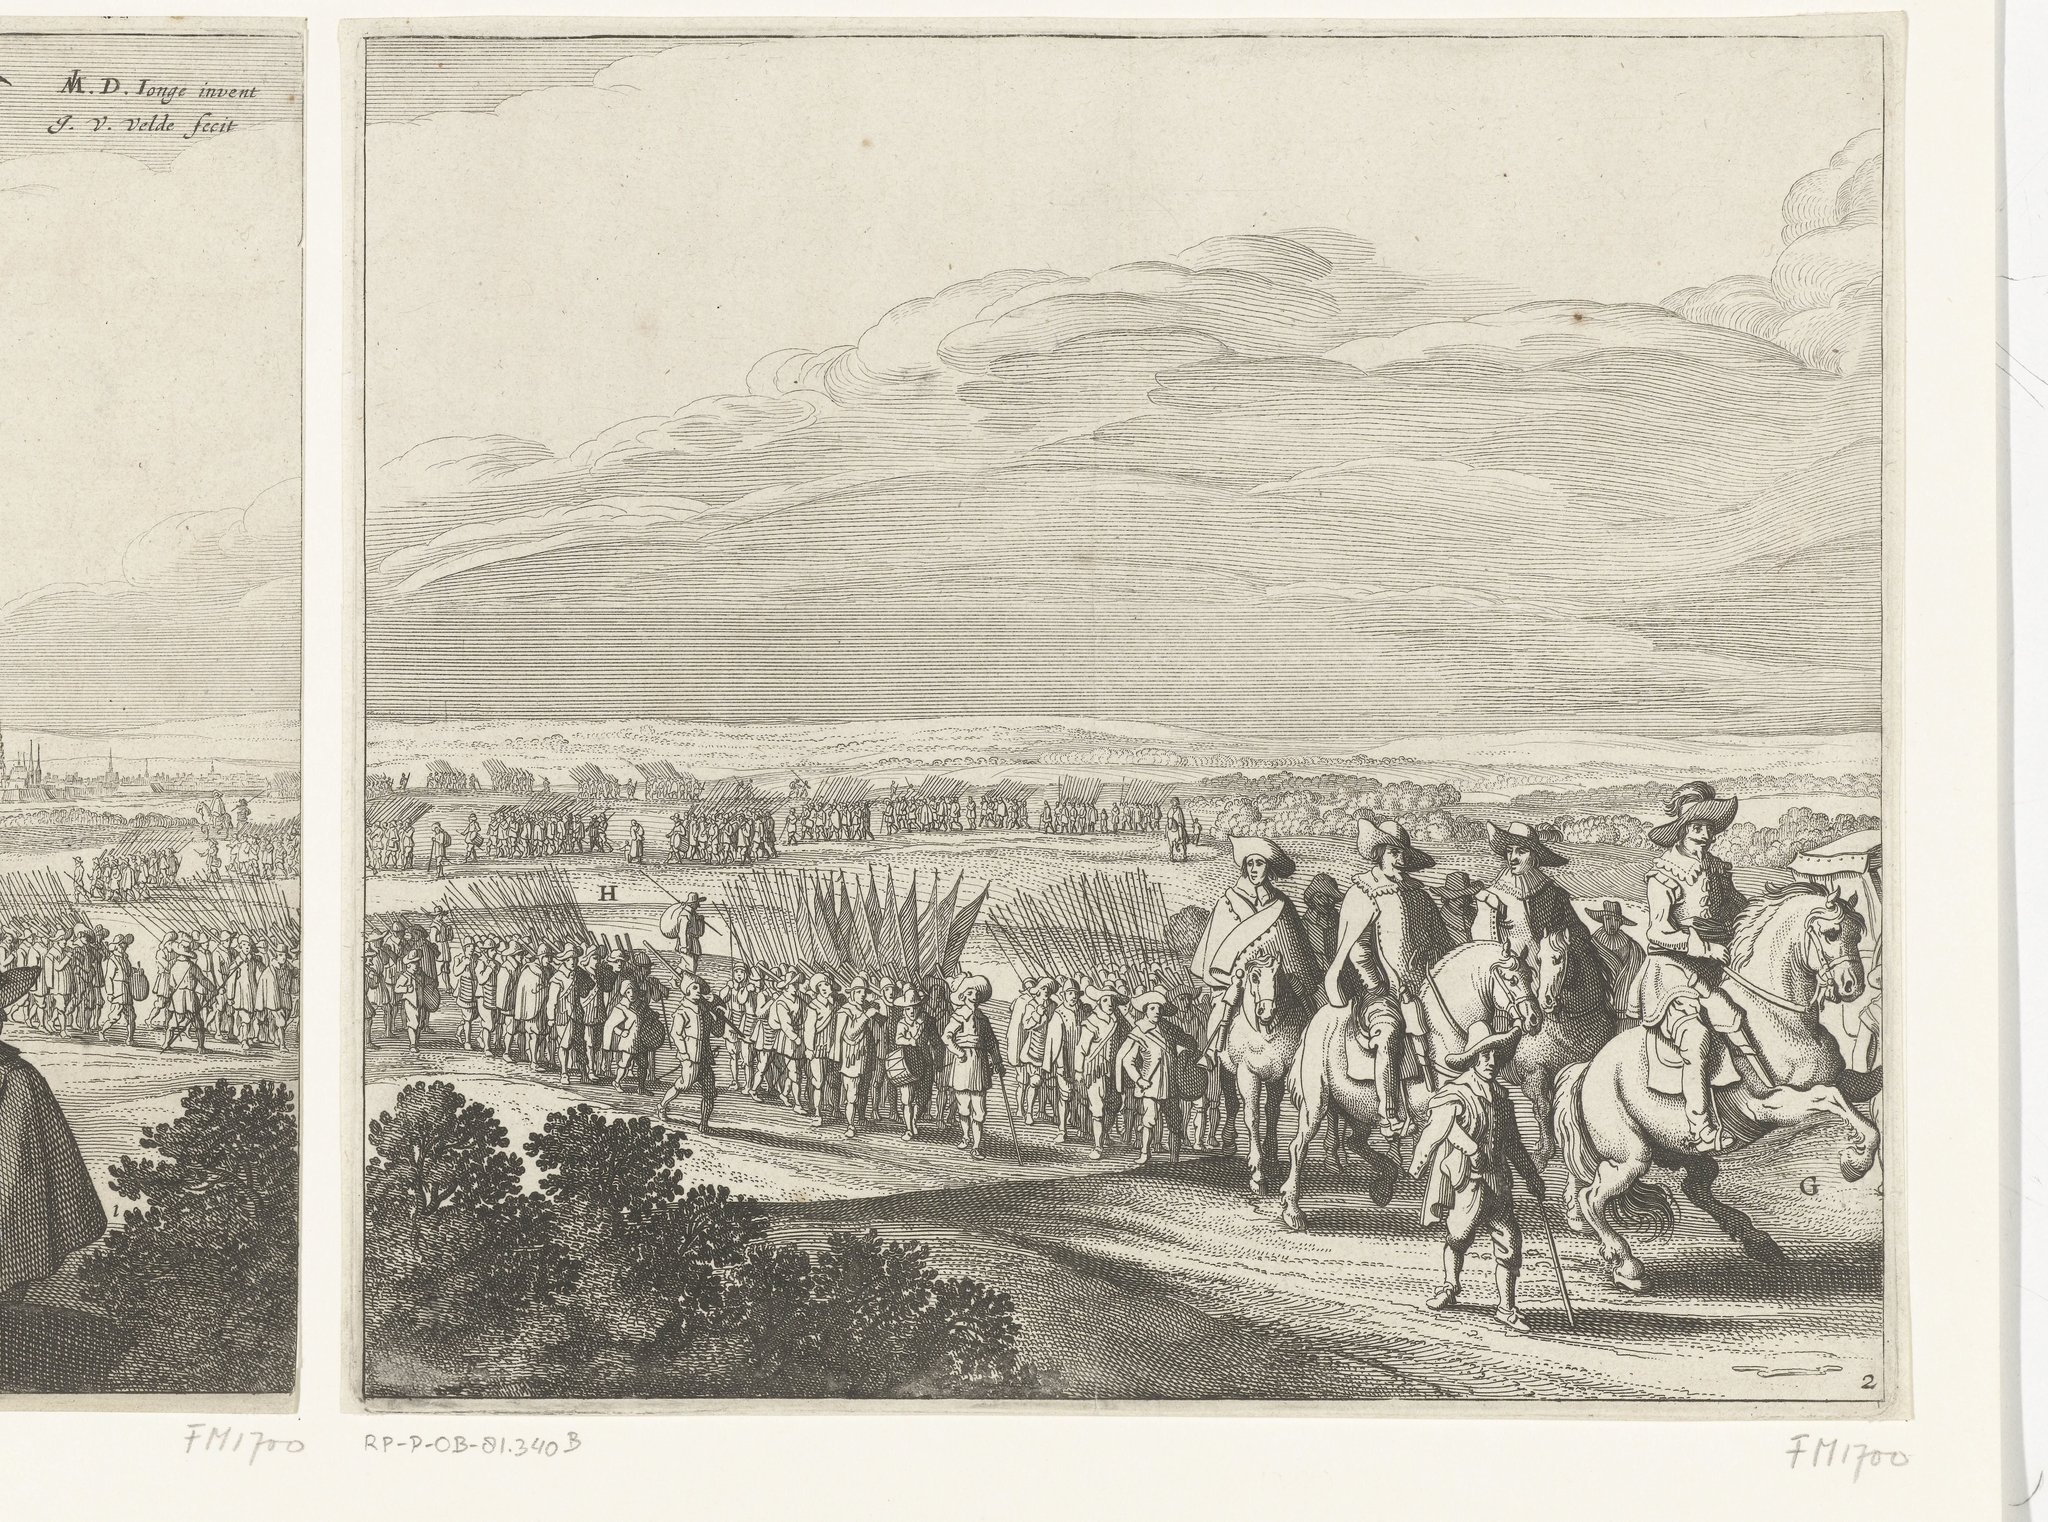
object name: print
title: Discessus Hispanici Praesidii Trajecti ad Mosam Ao. 1632. Die 23 Augusti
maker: jan van de velde (ii)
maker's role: draughtsman, painter, print maker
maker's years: 1593-1641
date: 1633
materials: paper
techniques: etching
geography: northern netherlands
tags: the hague, frederick henry (prince of orange), retreat of the defeated, maastricht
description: Uittocht van het Spaanse leger uit Maastricht, 23 augustus 1632. Fries van zes genummerd platen, plaat nr. 2. De stoet van vertrekkende soldaten.